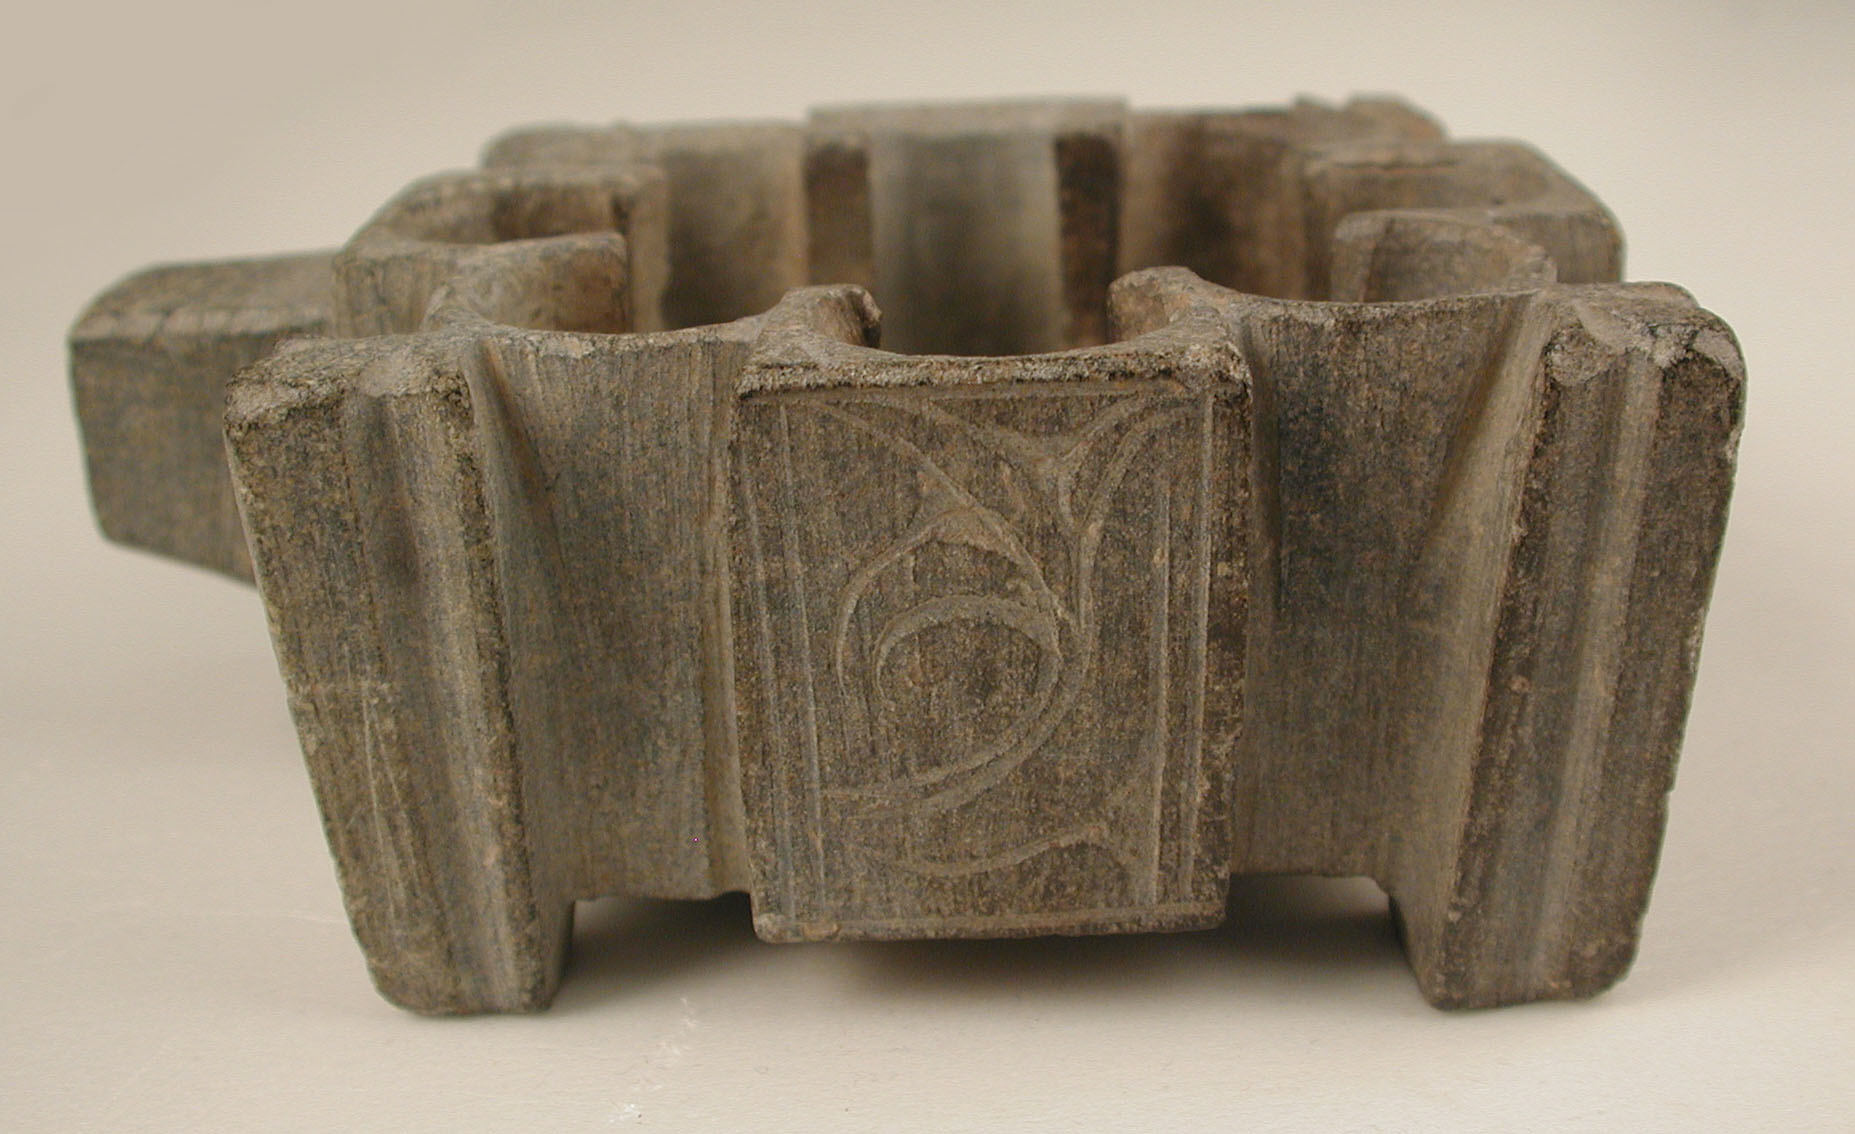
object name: lamp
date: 801-1000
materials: stone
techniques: carving, incising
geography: iran